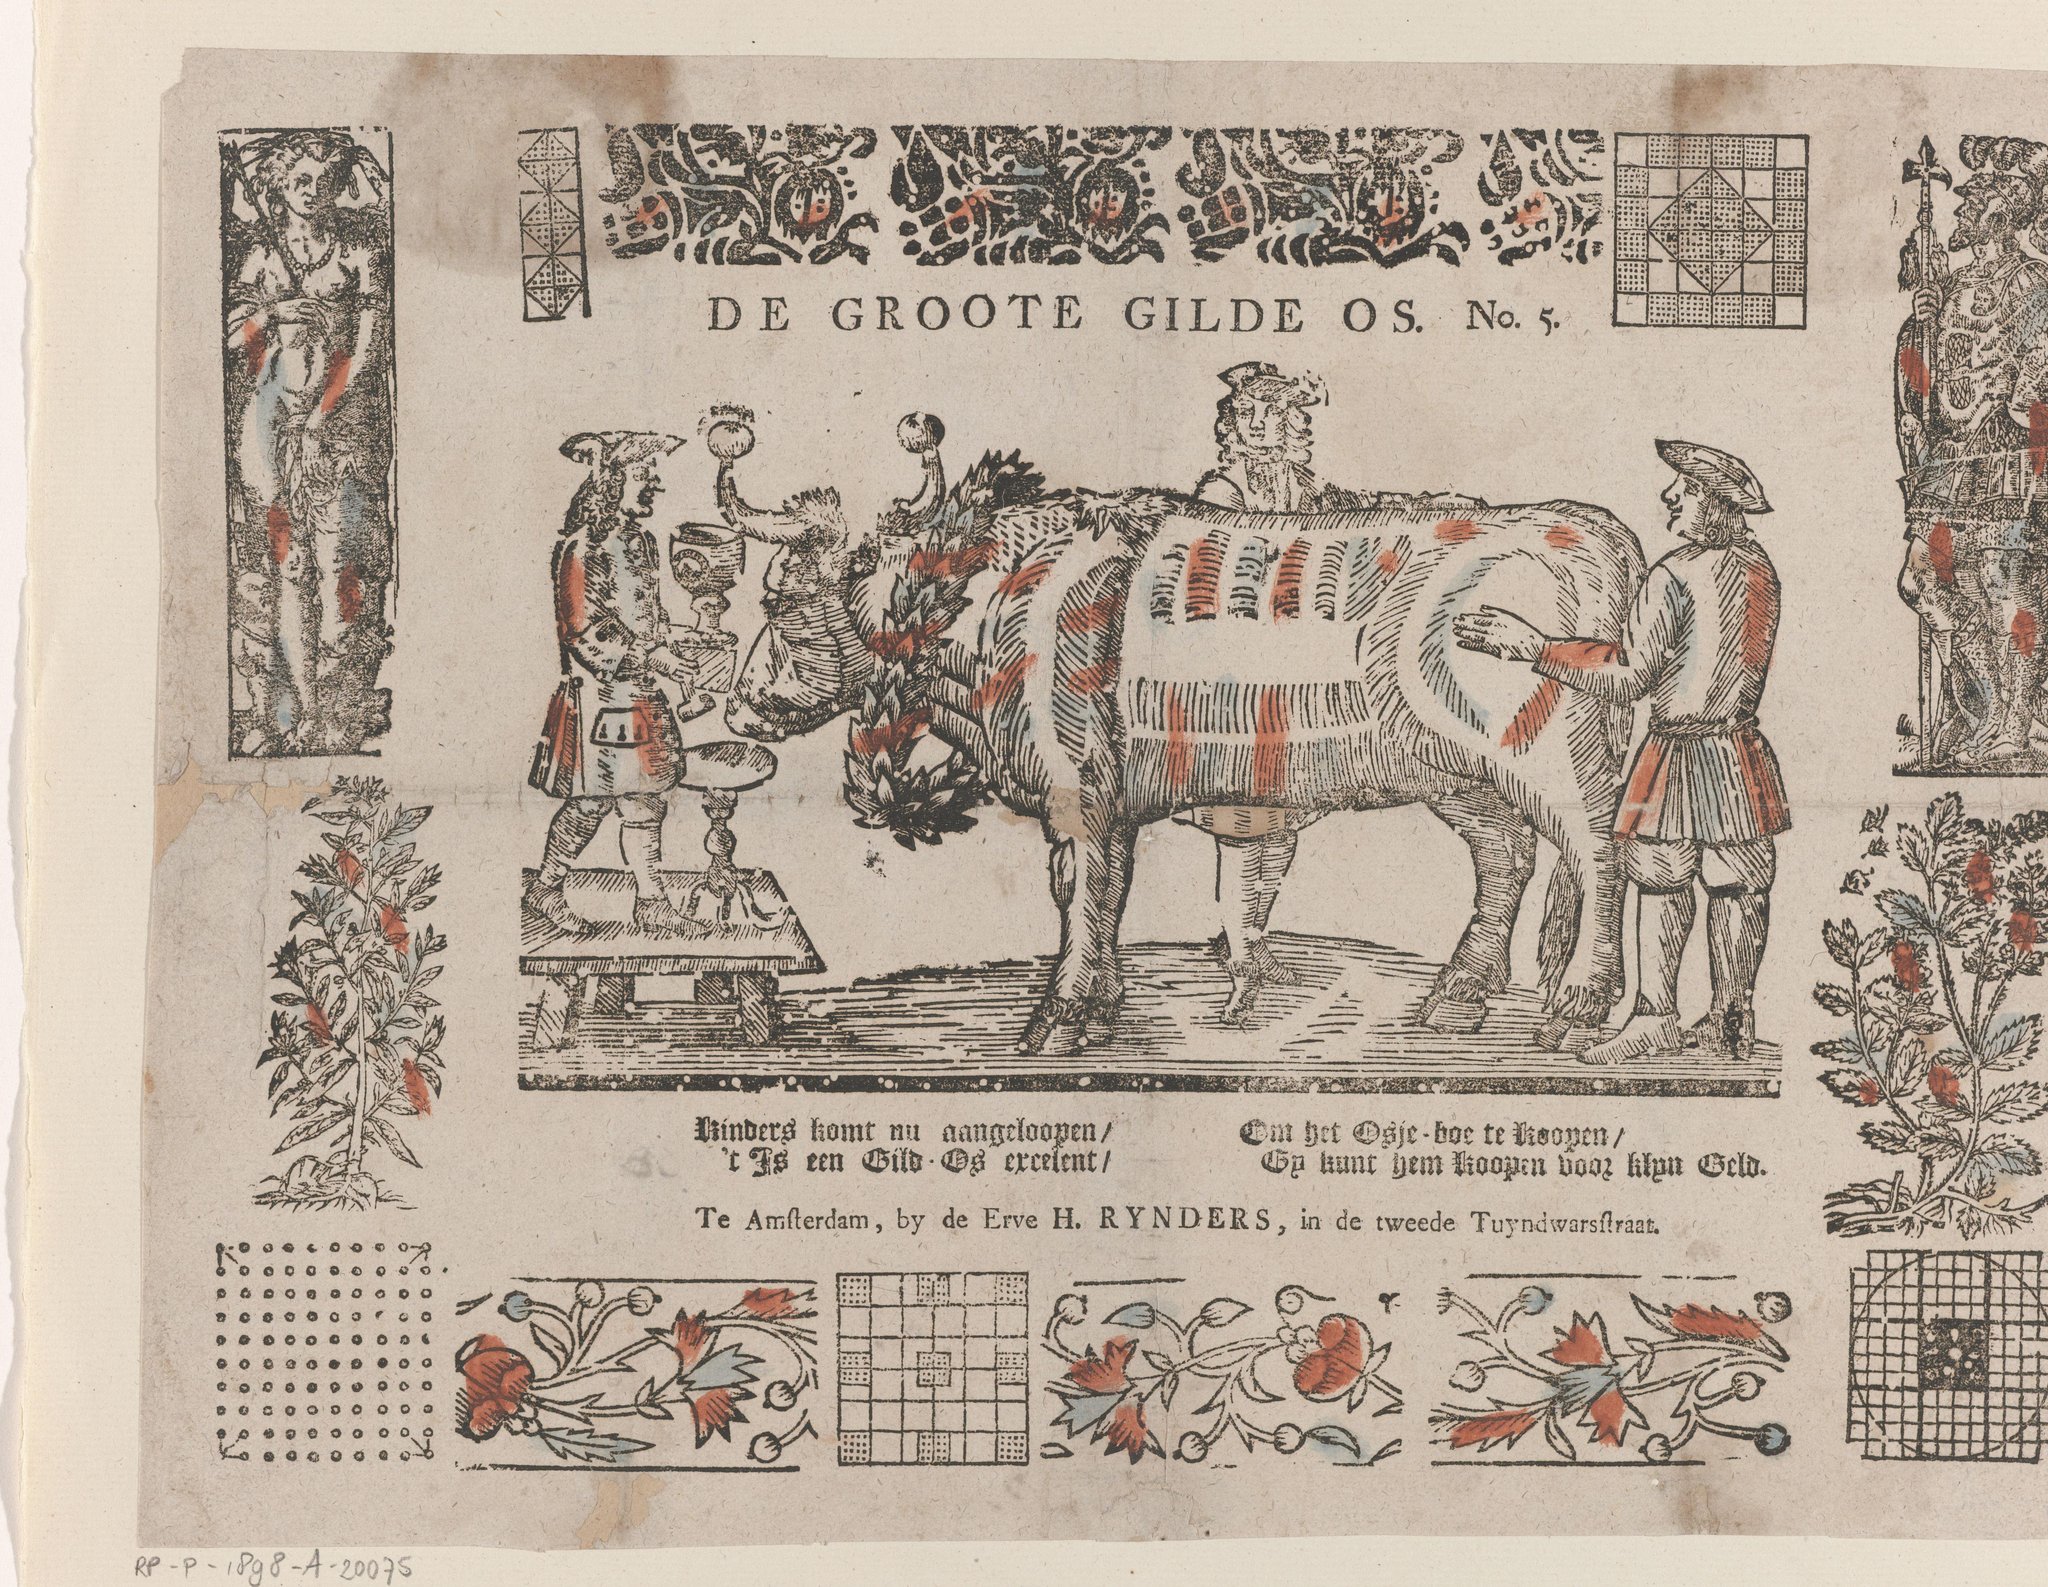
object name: print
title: De groote gilde os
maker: Anonymous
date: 1831-1854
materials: paper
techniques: colour, letterpress printing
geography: amsterdam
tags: floral interlace ~ ornament, prize-ox, ox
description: Blad met een grote voorstelling van een gilde-os (ook kermisos of prijsos genoemd), versierd met bloemenkransen. Onder de voorstelling een vierregelig vers in twee kolommen. De voorstelling is gevat in een sierlijst van 16 kleine voorstellingen van verschillende aard, zoals voorstellingen van ranken en planten. Genummerd: No. 5.